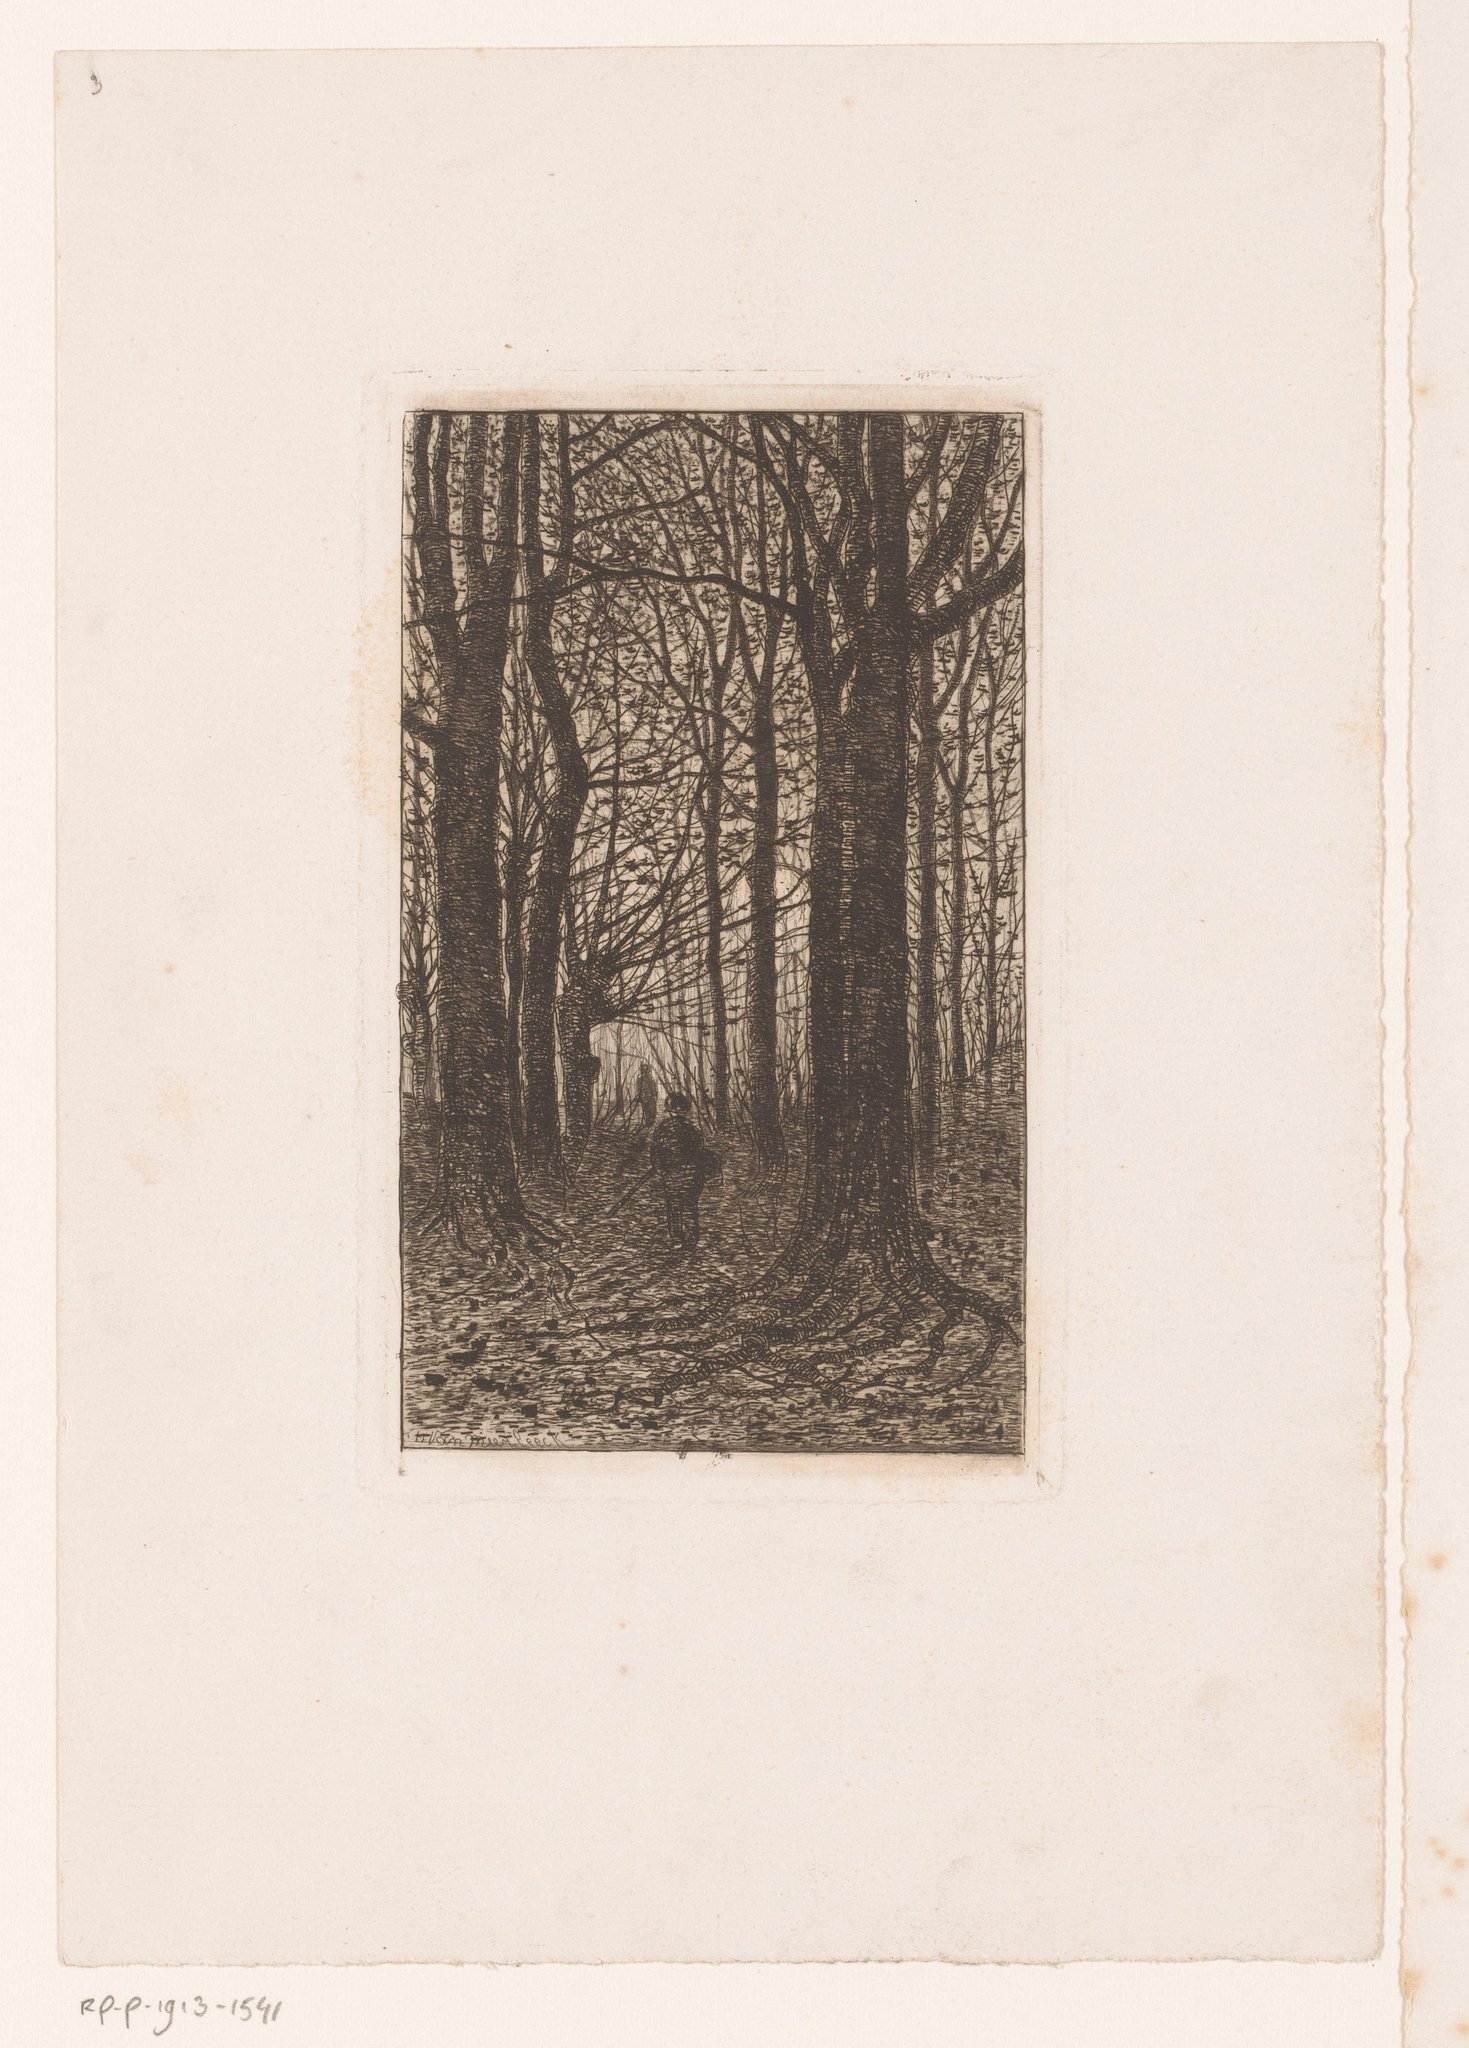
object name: print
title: Twee figuren in een bos met hoge bomen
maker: h. van meerbeeck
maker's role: print maker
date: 1850-1913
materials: paper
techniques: etching, intaglio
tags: moonlight, forest, wood (+ landscape with figures, staffage)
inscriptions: collector's mark: Lugt 2228